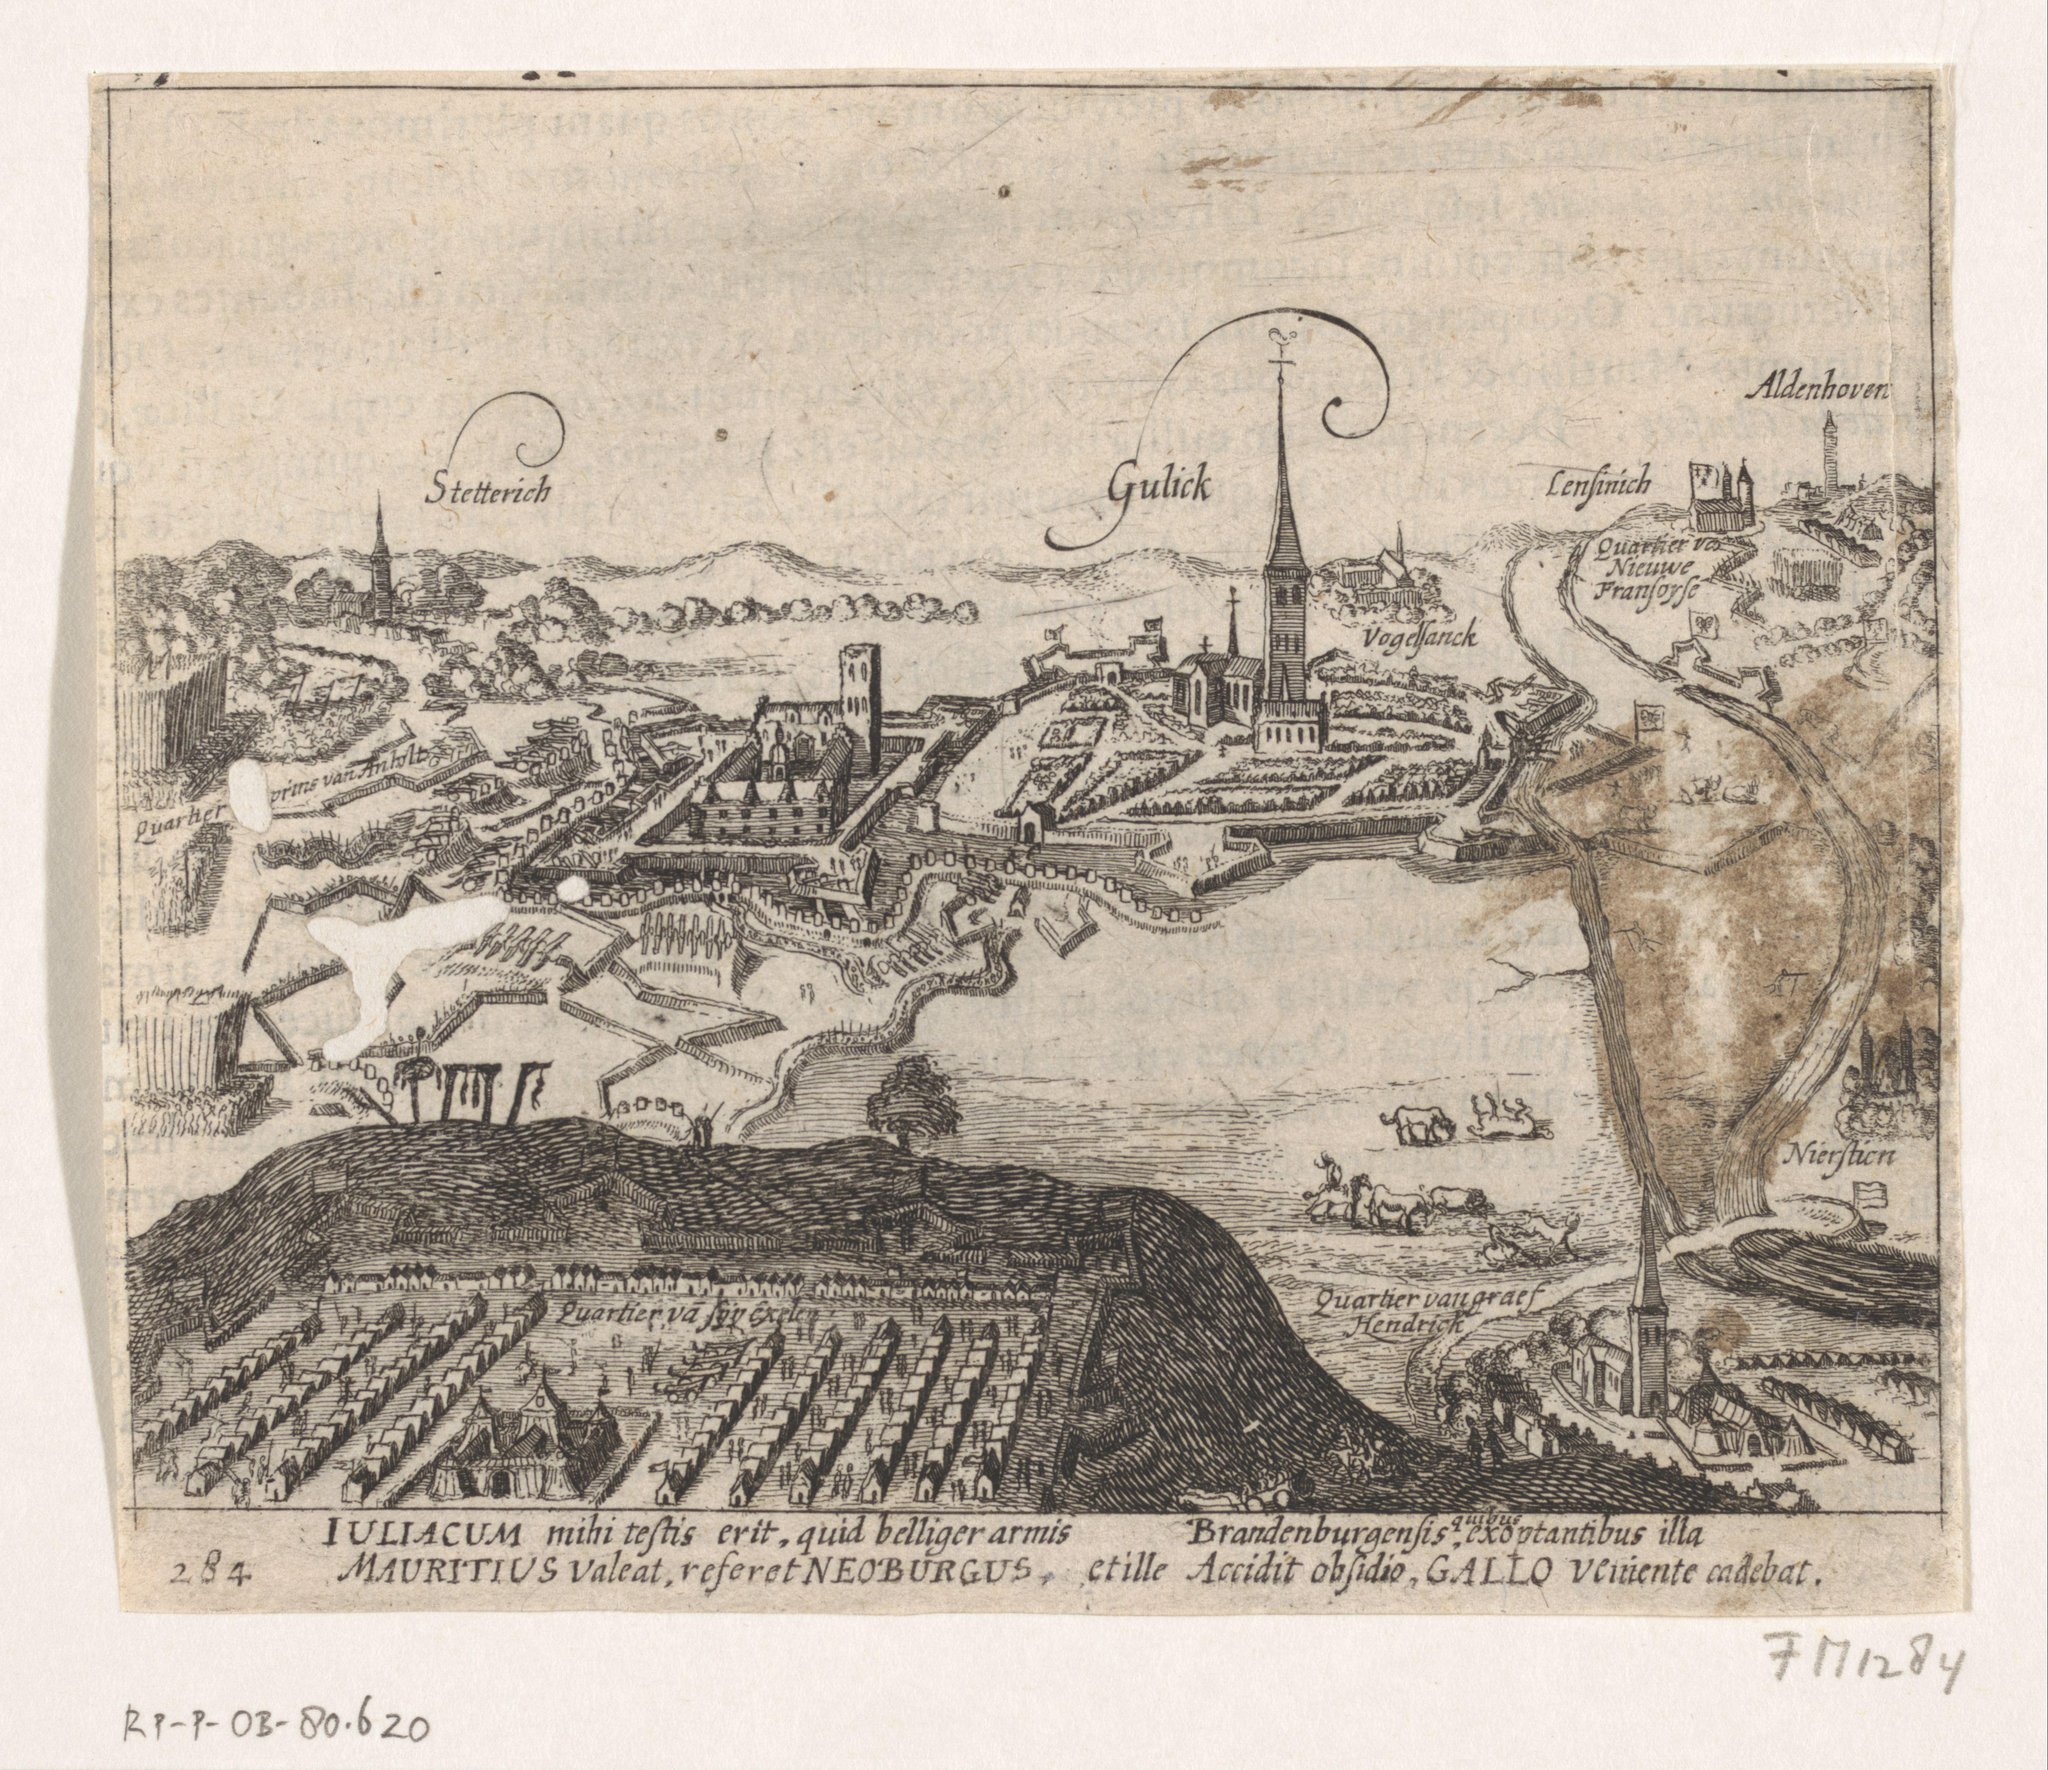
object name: print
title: Prins Maurits belegert Gulik, 1610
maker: simon frisius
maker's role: print maker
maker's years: 1570-1628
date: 1613-1615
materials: paper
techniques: etching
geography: northern netherlands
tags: maurice (prince of orange), siege, position war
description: Prins Maurits belegert Gulik, 1610. Op de voorgrond het legerkamop van Maurits, linksboven het kwartier van de vorst van Anhalt. Ook met enkele naburige dorpen. Met onderschrift van 4 regels in het Latijn. Genummerd: 284. Bedrukt op achterzijde met tekst in het Latijn.